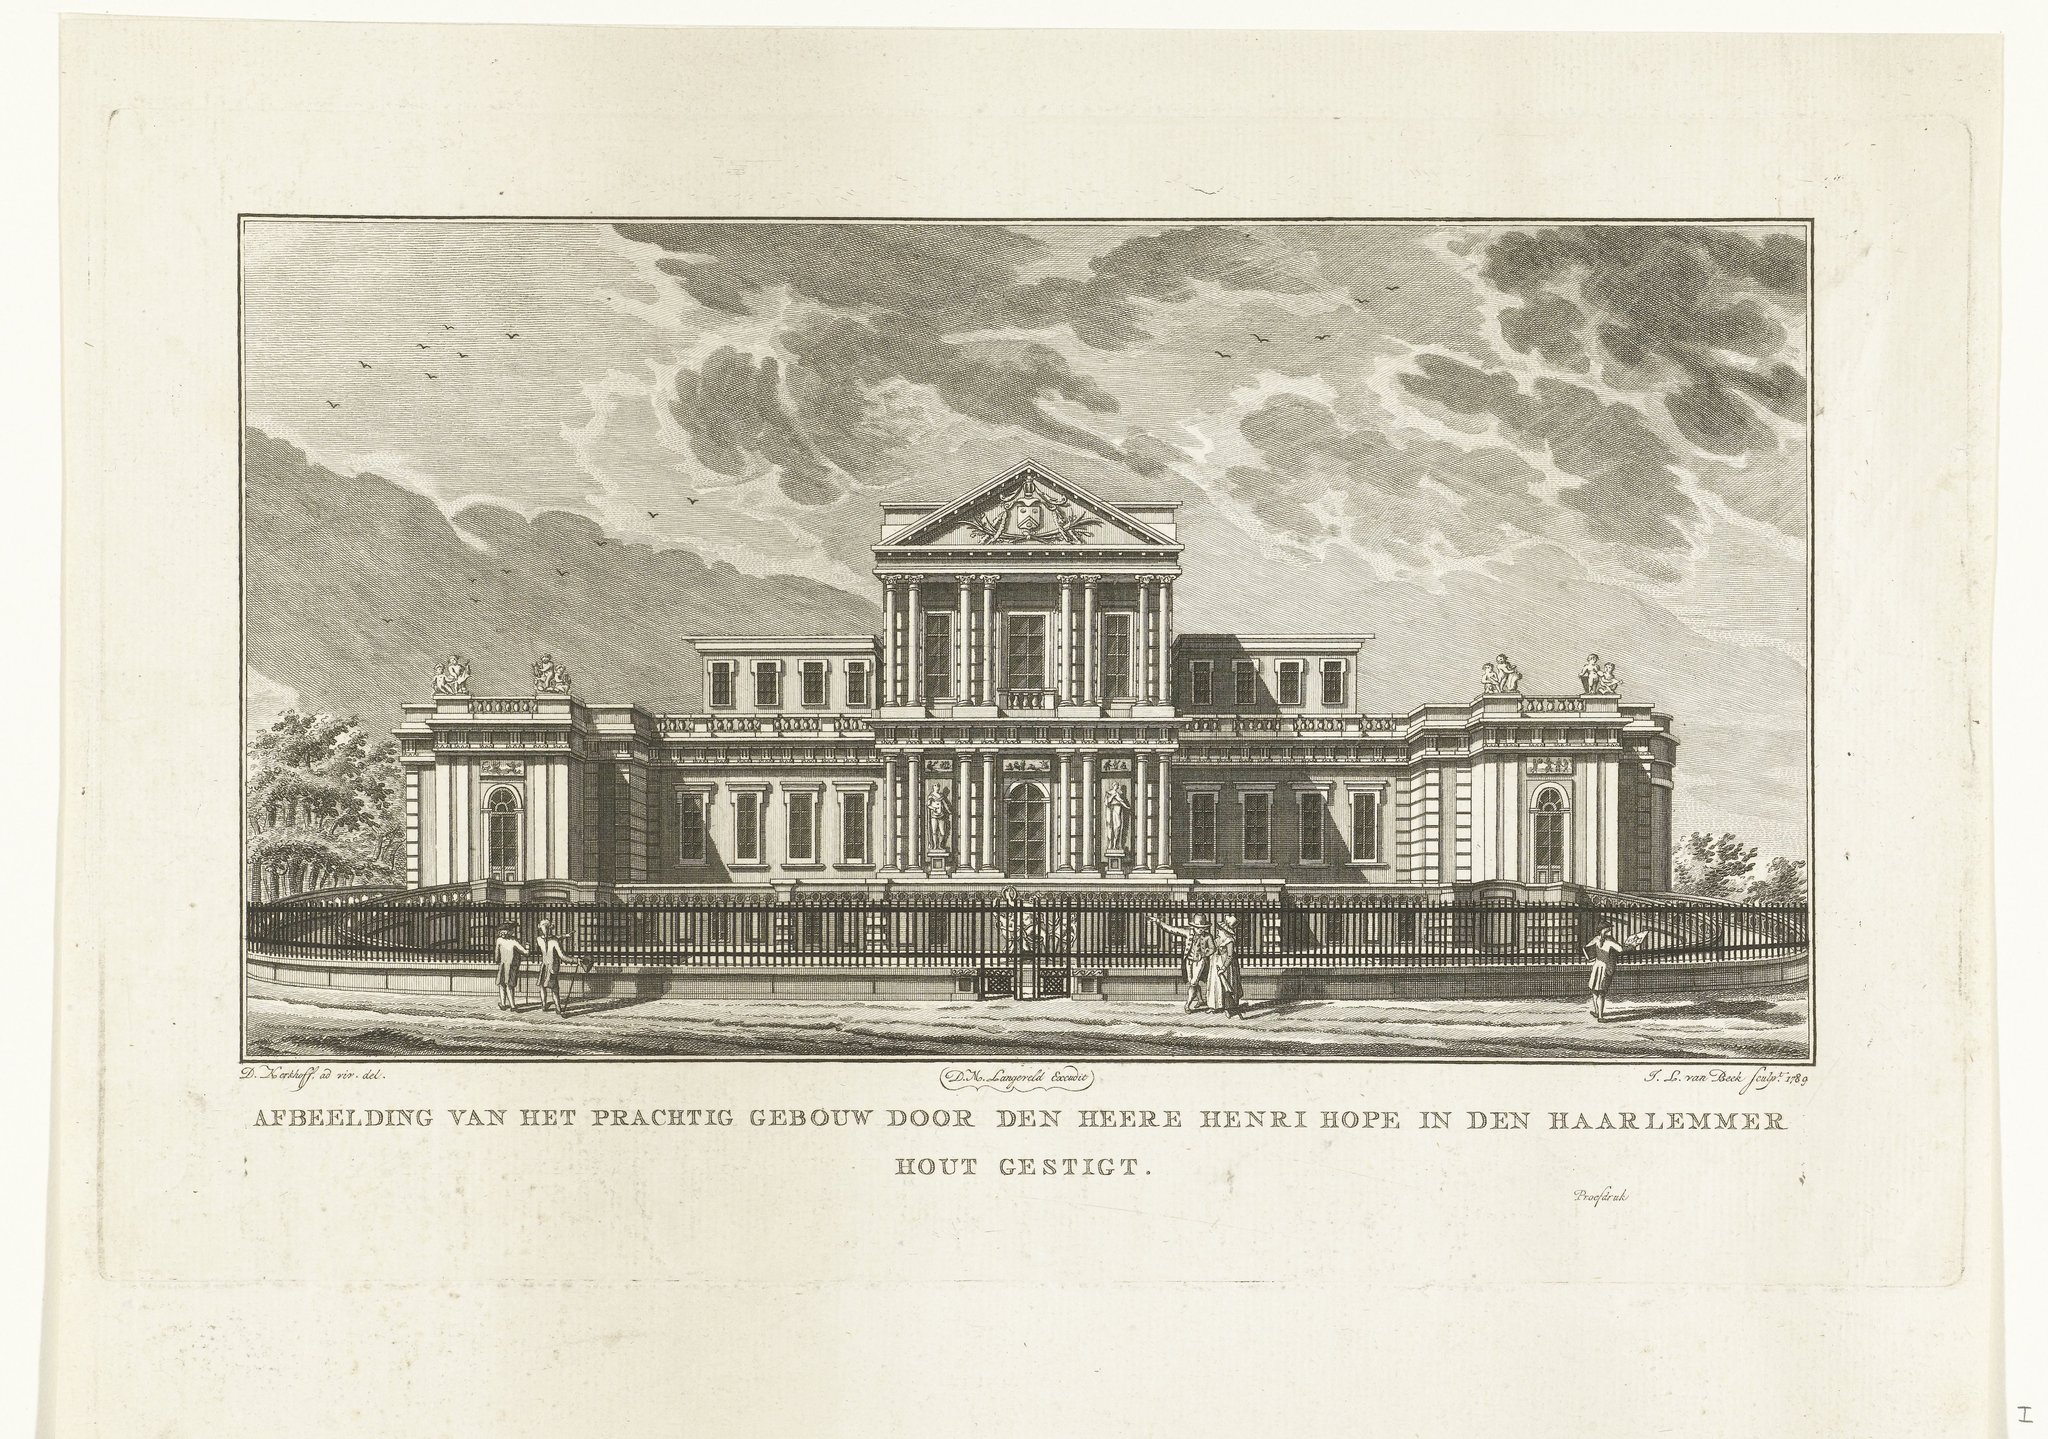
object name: print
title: Afbeelding van het prachtige gebouw door den heere Henri Hope in den Haarlemmerhout gestigt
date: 1789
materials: paper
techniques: etching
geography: amsterdam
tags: country-house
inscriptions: collector's mark: Lugt 2233, collector's mark: Lugt 2228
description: Prent naar tekening van Daniël Kerkhoff.